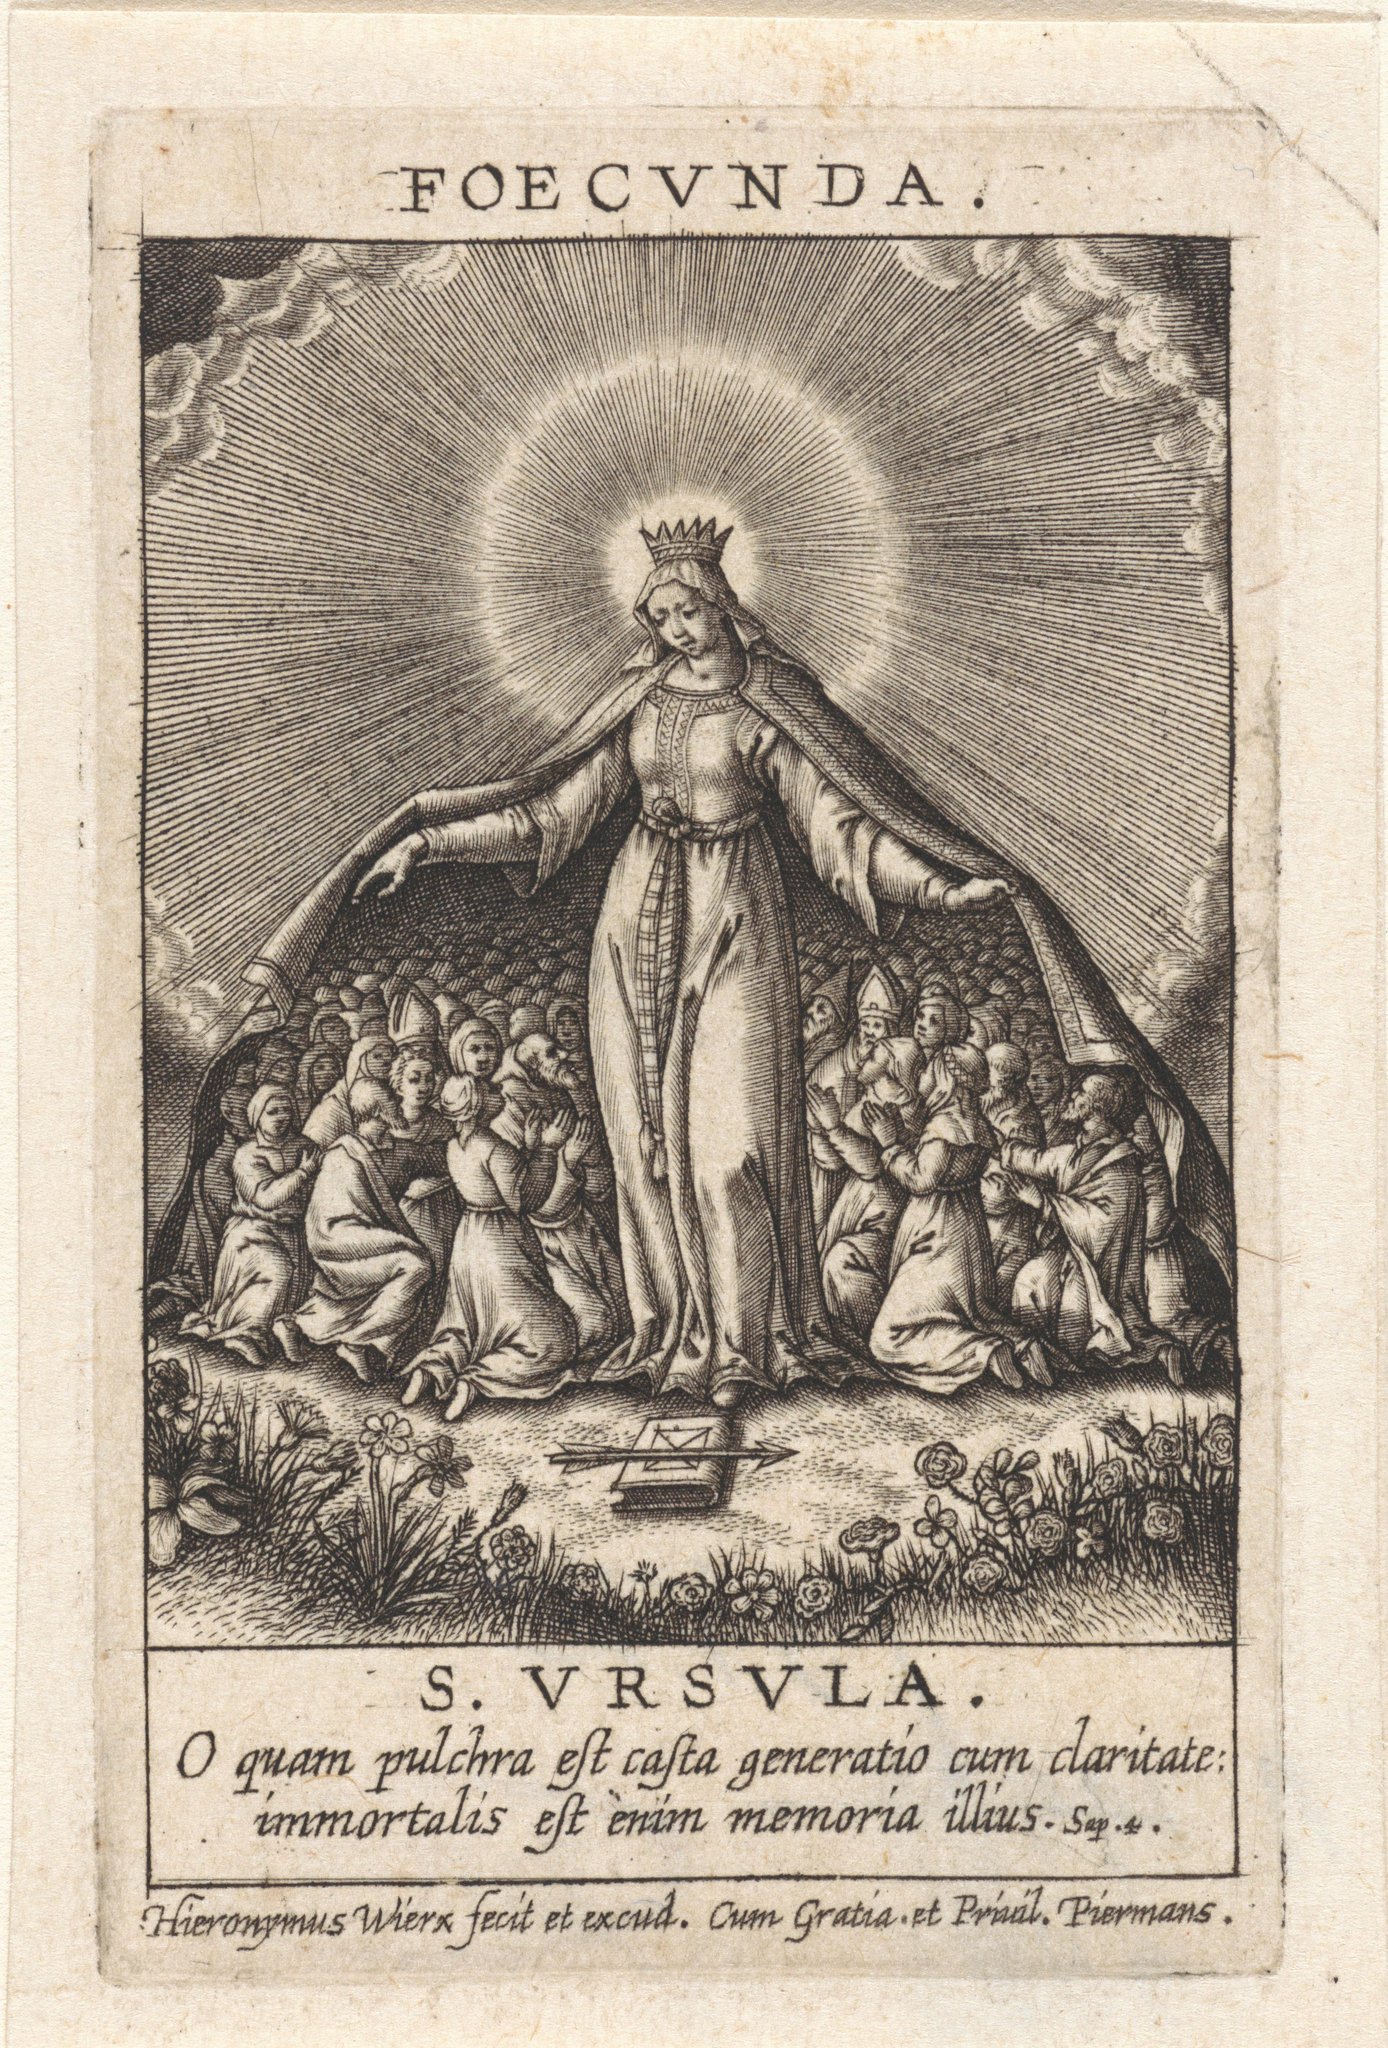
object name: print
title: Deugdzaamheid van de vruchtbaren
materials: paper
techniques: engraving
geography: antwerp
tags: st. ursula as patron, protector, intercessor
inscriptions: collector's mark: Lugt 2228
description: De heilige Ursula, met haar mantel aan beide zijden uitgespreid om een schuilplaats te bieden aan mannen en vrouwen. Aan haar voeten ligt een boek met een pijl erop. In de marge een tweeregelig Bijbelcitaat uit Wijsh. 4 in het Latijn.